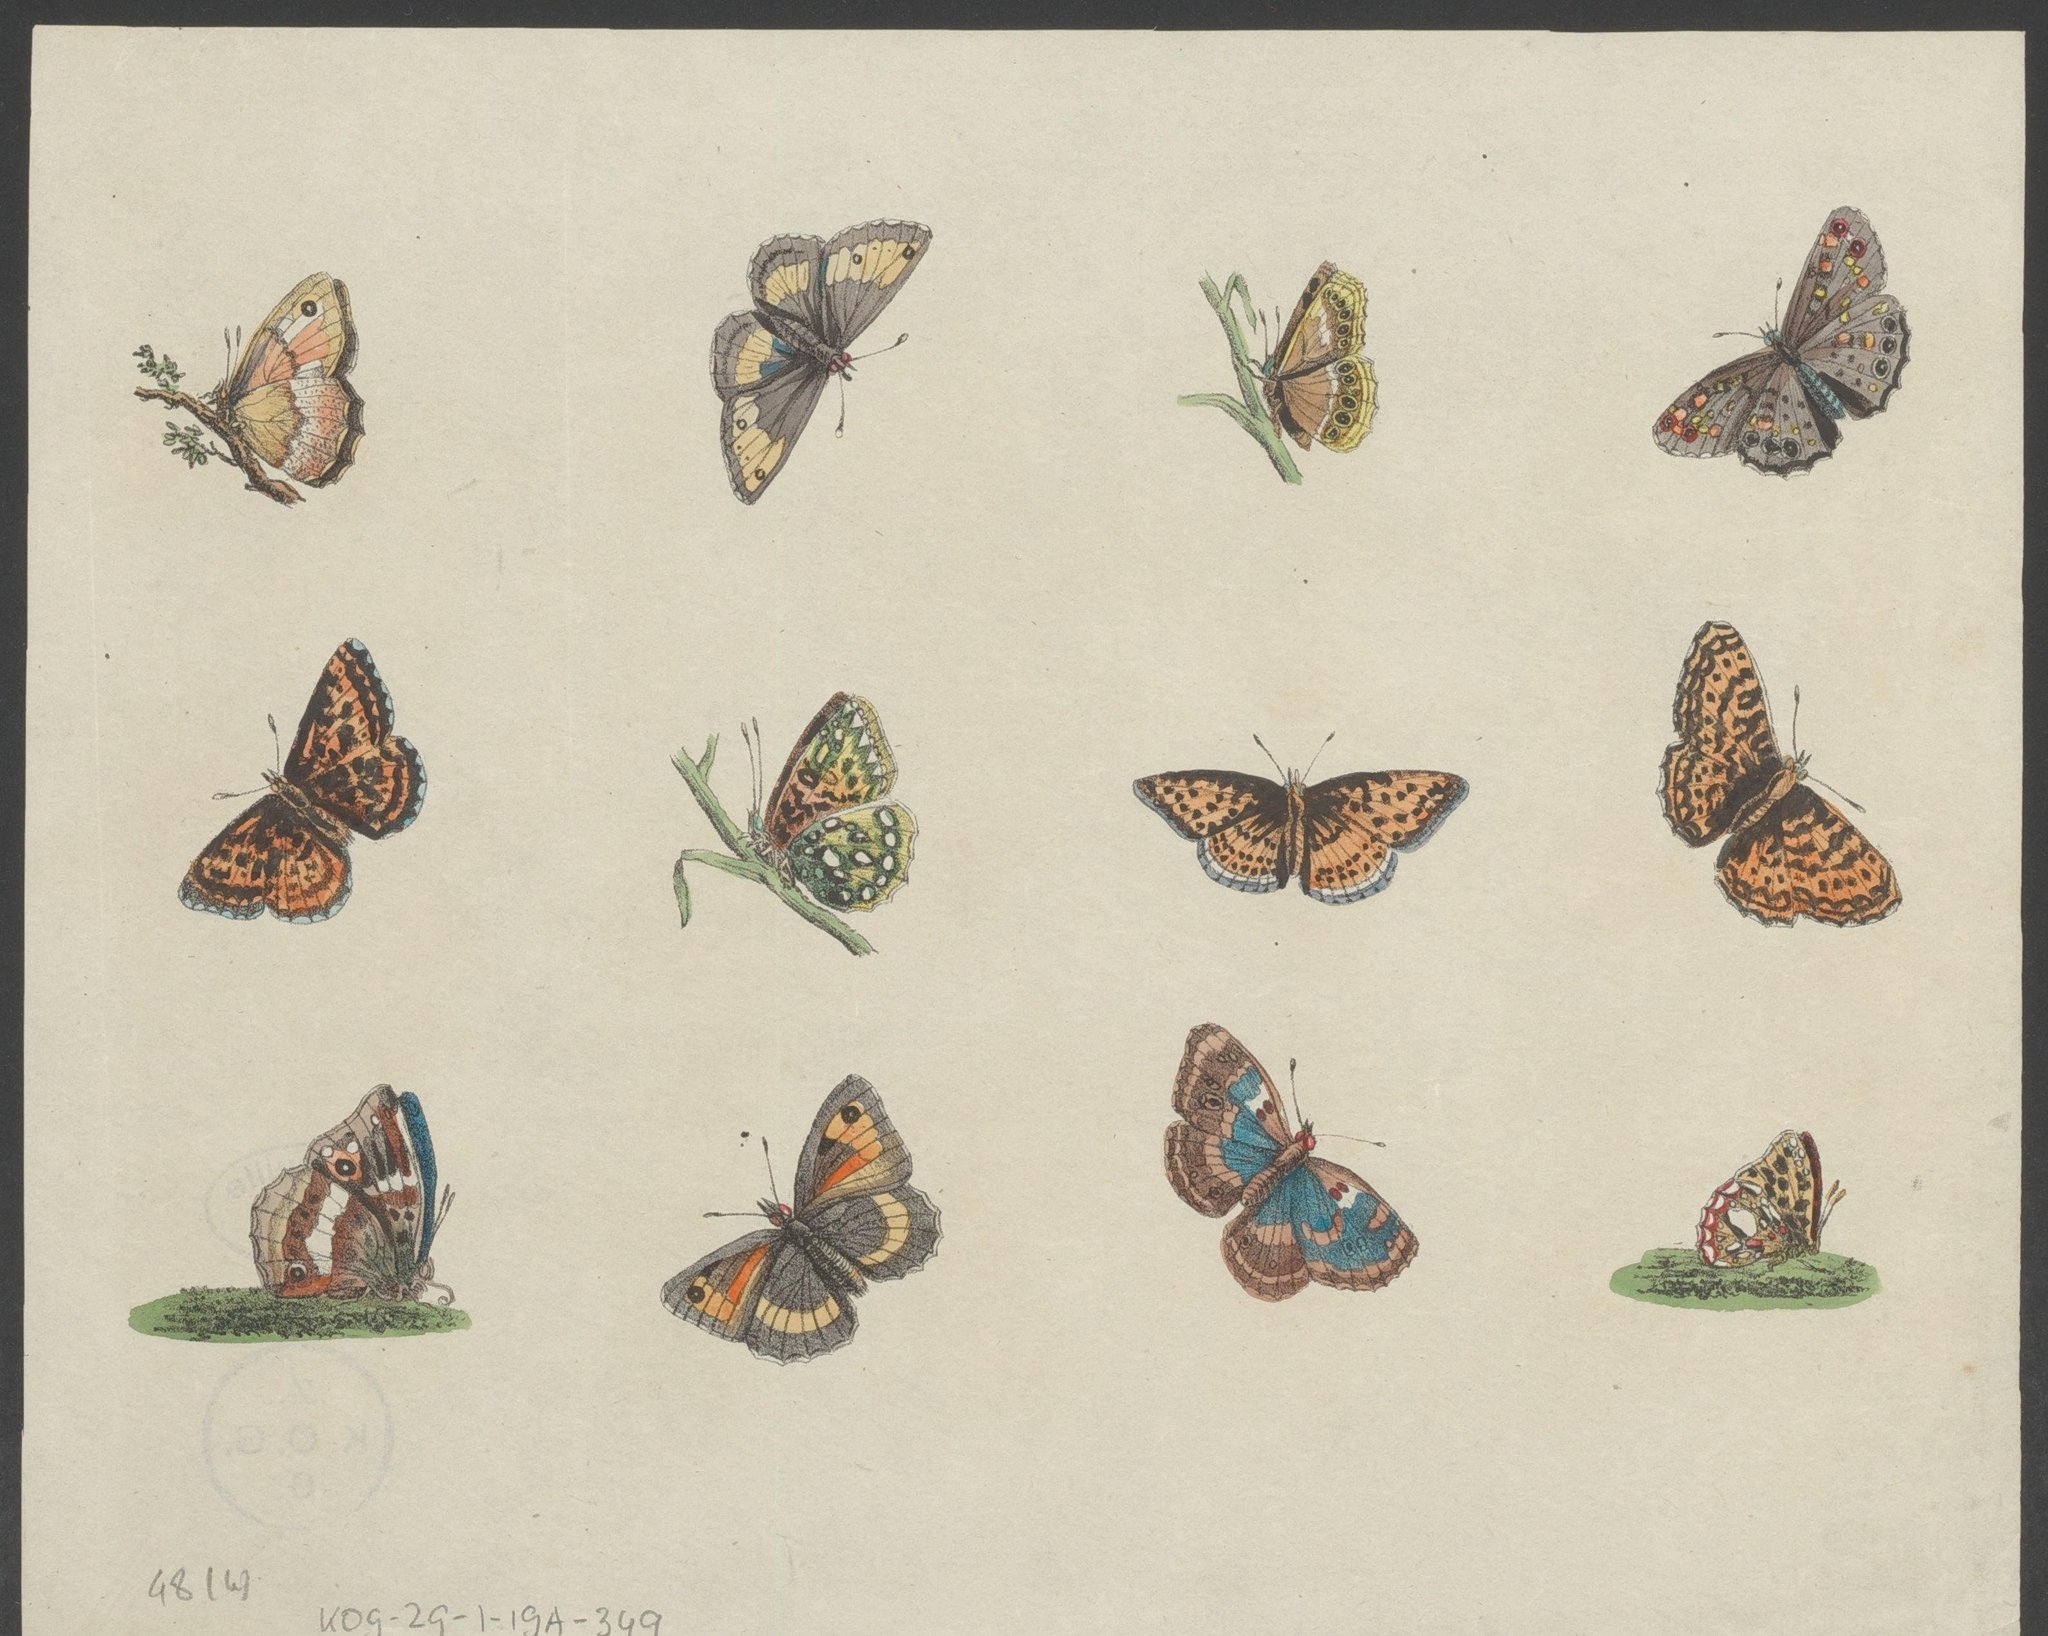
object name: print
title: Twaalf vlinders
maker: Anonymous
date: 1800-1899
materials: paper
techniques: hand coloring, lithograph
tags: insects: butterfly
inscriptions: stamp, collector's mark: Lugt 1641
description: Twaalf vlinders in drie rijen van vier. Onderwerpsrubrieken binnen de Atlas Zeden en Gewoonten: Zeden en Gewoonten in Engeren Zin, Des menschen beging, midden en einde, Kinderleven – Kinderspel en Kinderprenten.